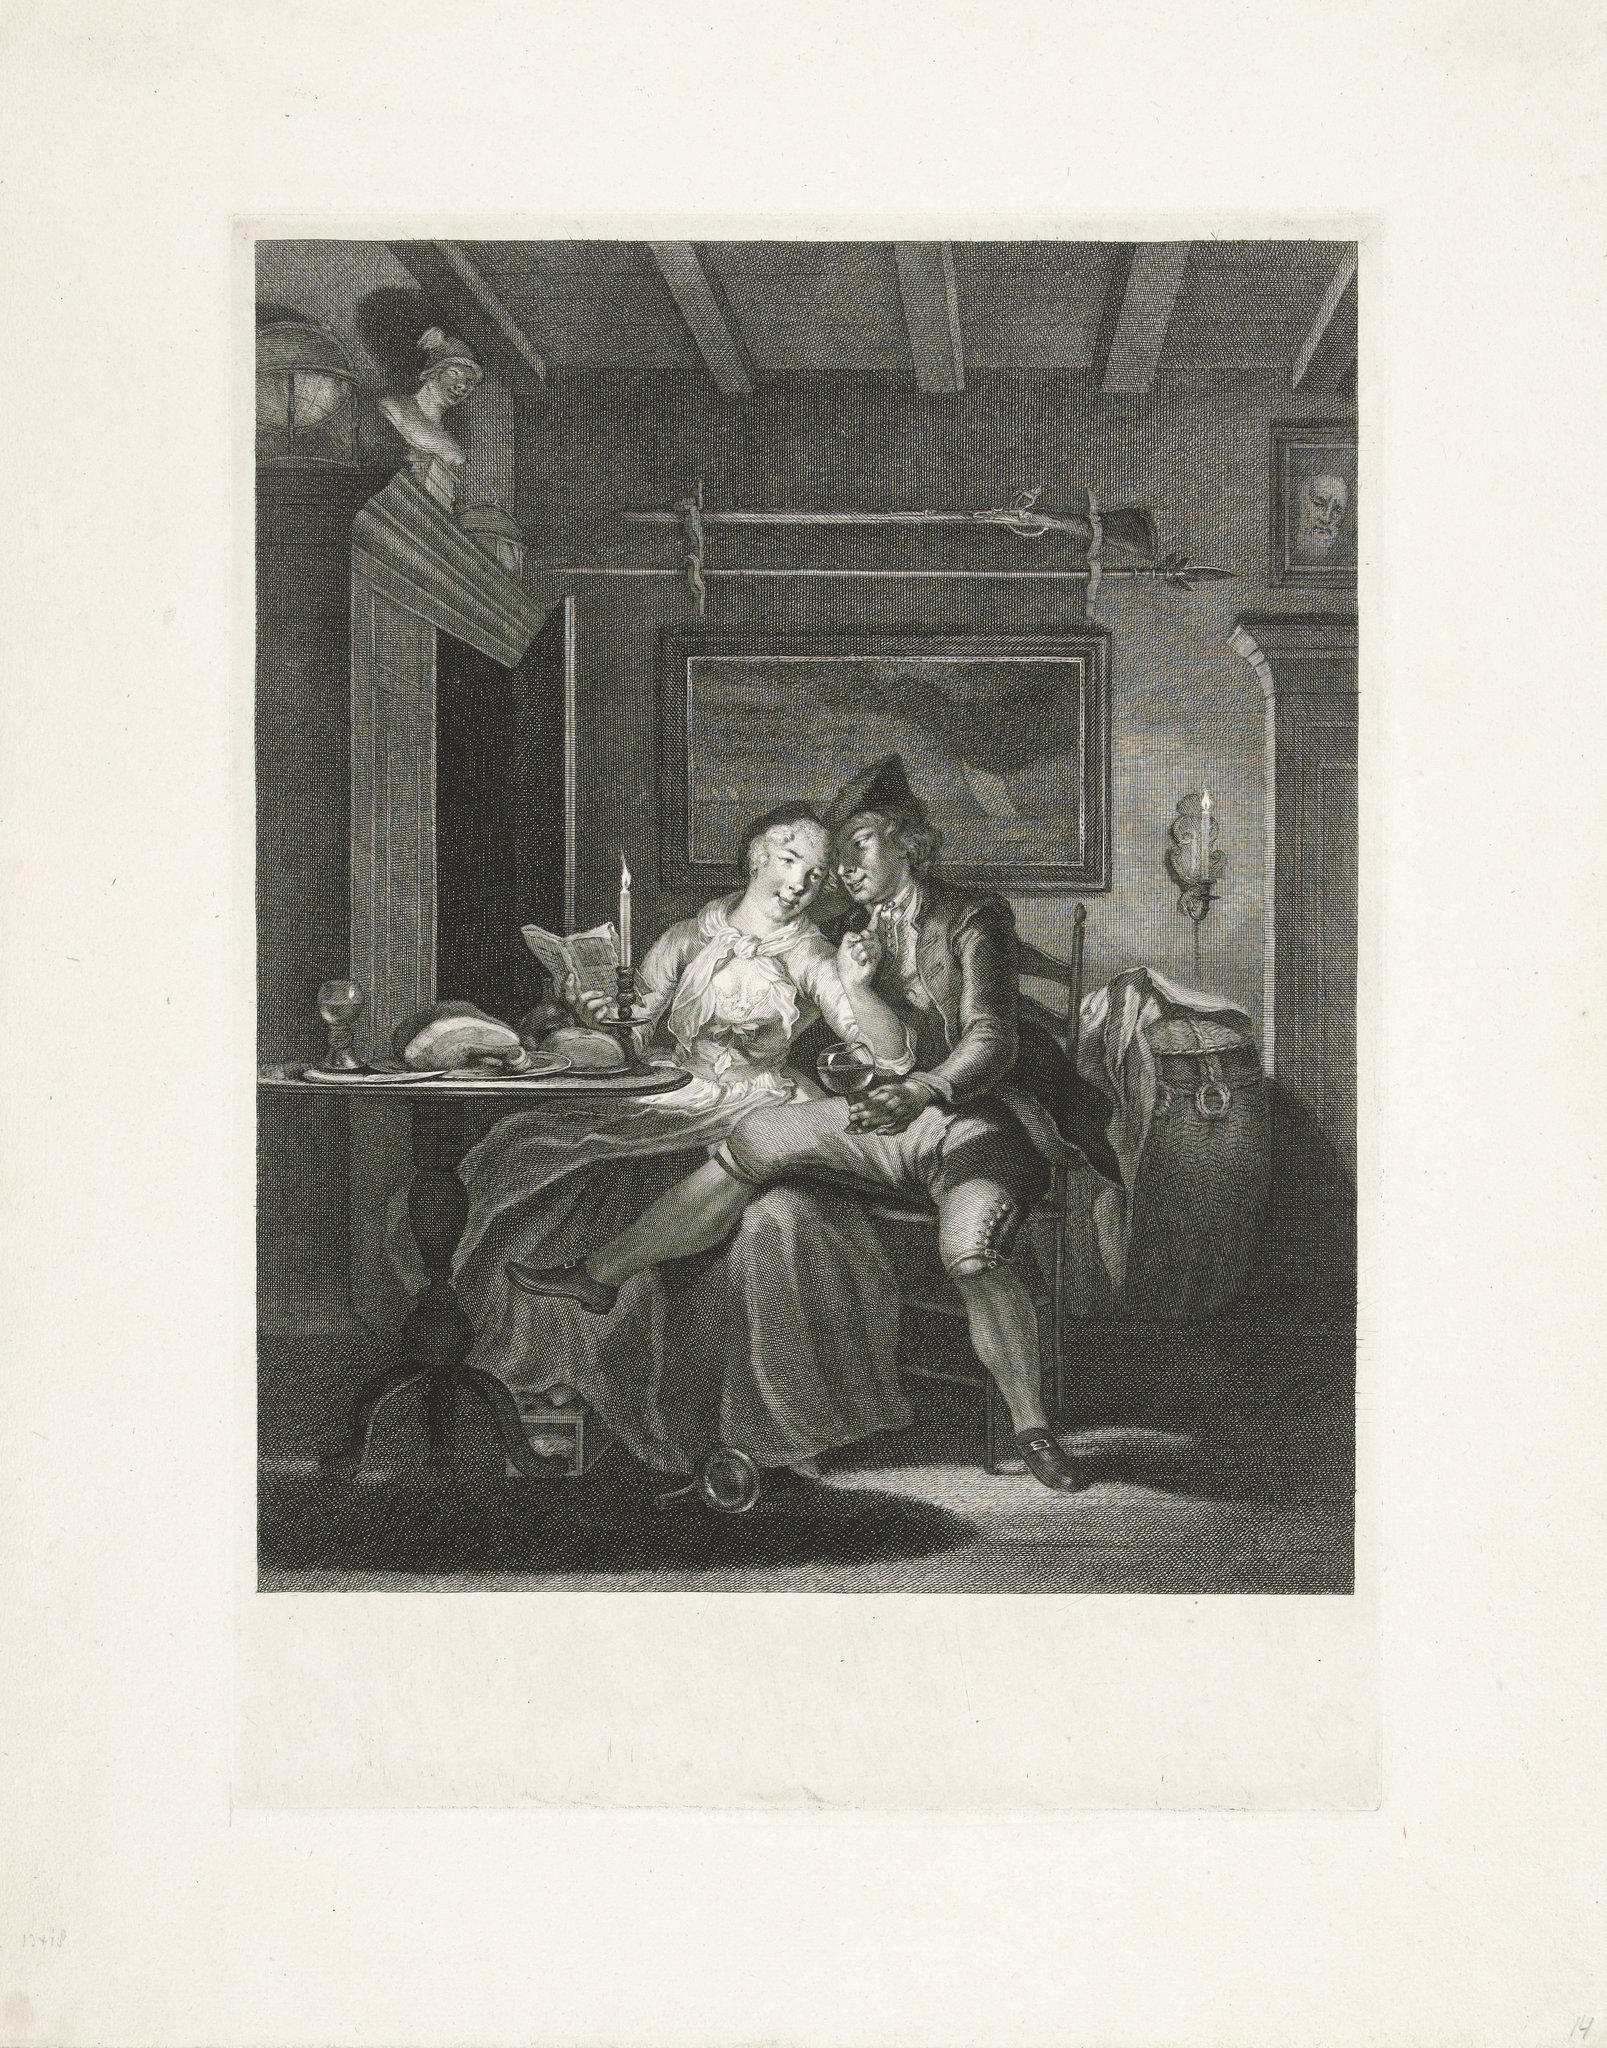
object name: print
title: De Ontdekte Schijndeugd: Bely en Dirk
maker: jacob houbraken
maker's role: draughtsman, print maker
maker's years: 1698-1780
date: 1754-1764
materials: paper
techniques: engraving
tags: glass, rummer, candlestick, lovers; courting, flirting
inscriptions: collector's mark: Lugt 240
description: Dienstmeid met haar vrijer. Volgens het gedicht onder de prent profiteert een dienstbode van de afwezigheid van haar werkgevers. Met haar vrijer zit zij bij een tafeltje in de kamer van mevrouw te drinken en te eten bij kaarslicht. Tegen de wand staat een grote wasmand. De dienstmeid Bely maakt plezier met haar vrijer Dirk. Scène uit het blijspel De Ontdekte Schijndeugd van David Lingelbach uit 1687. Onderaan twee zesregelige verzen in het Nederlands en in het Frans.